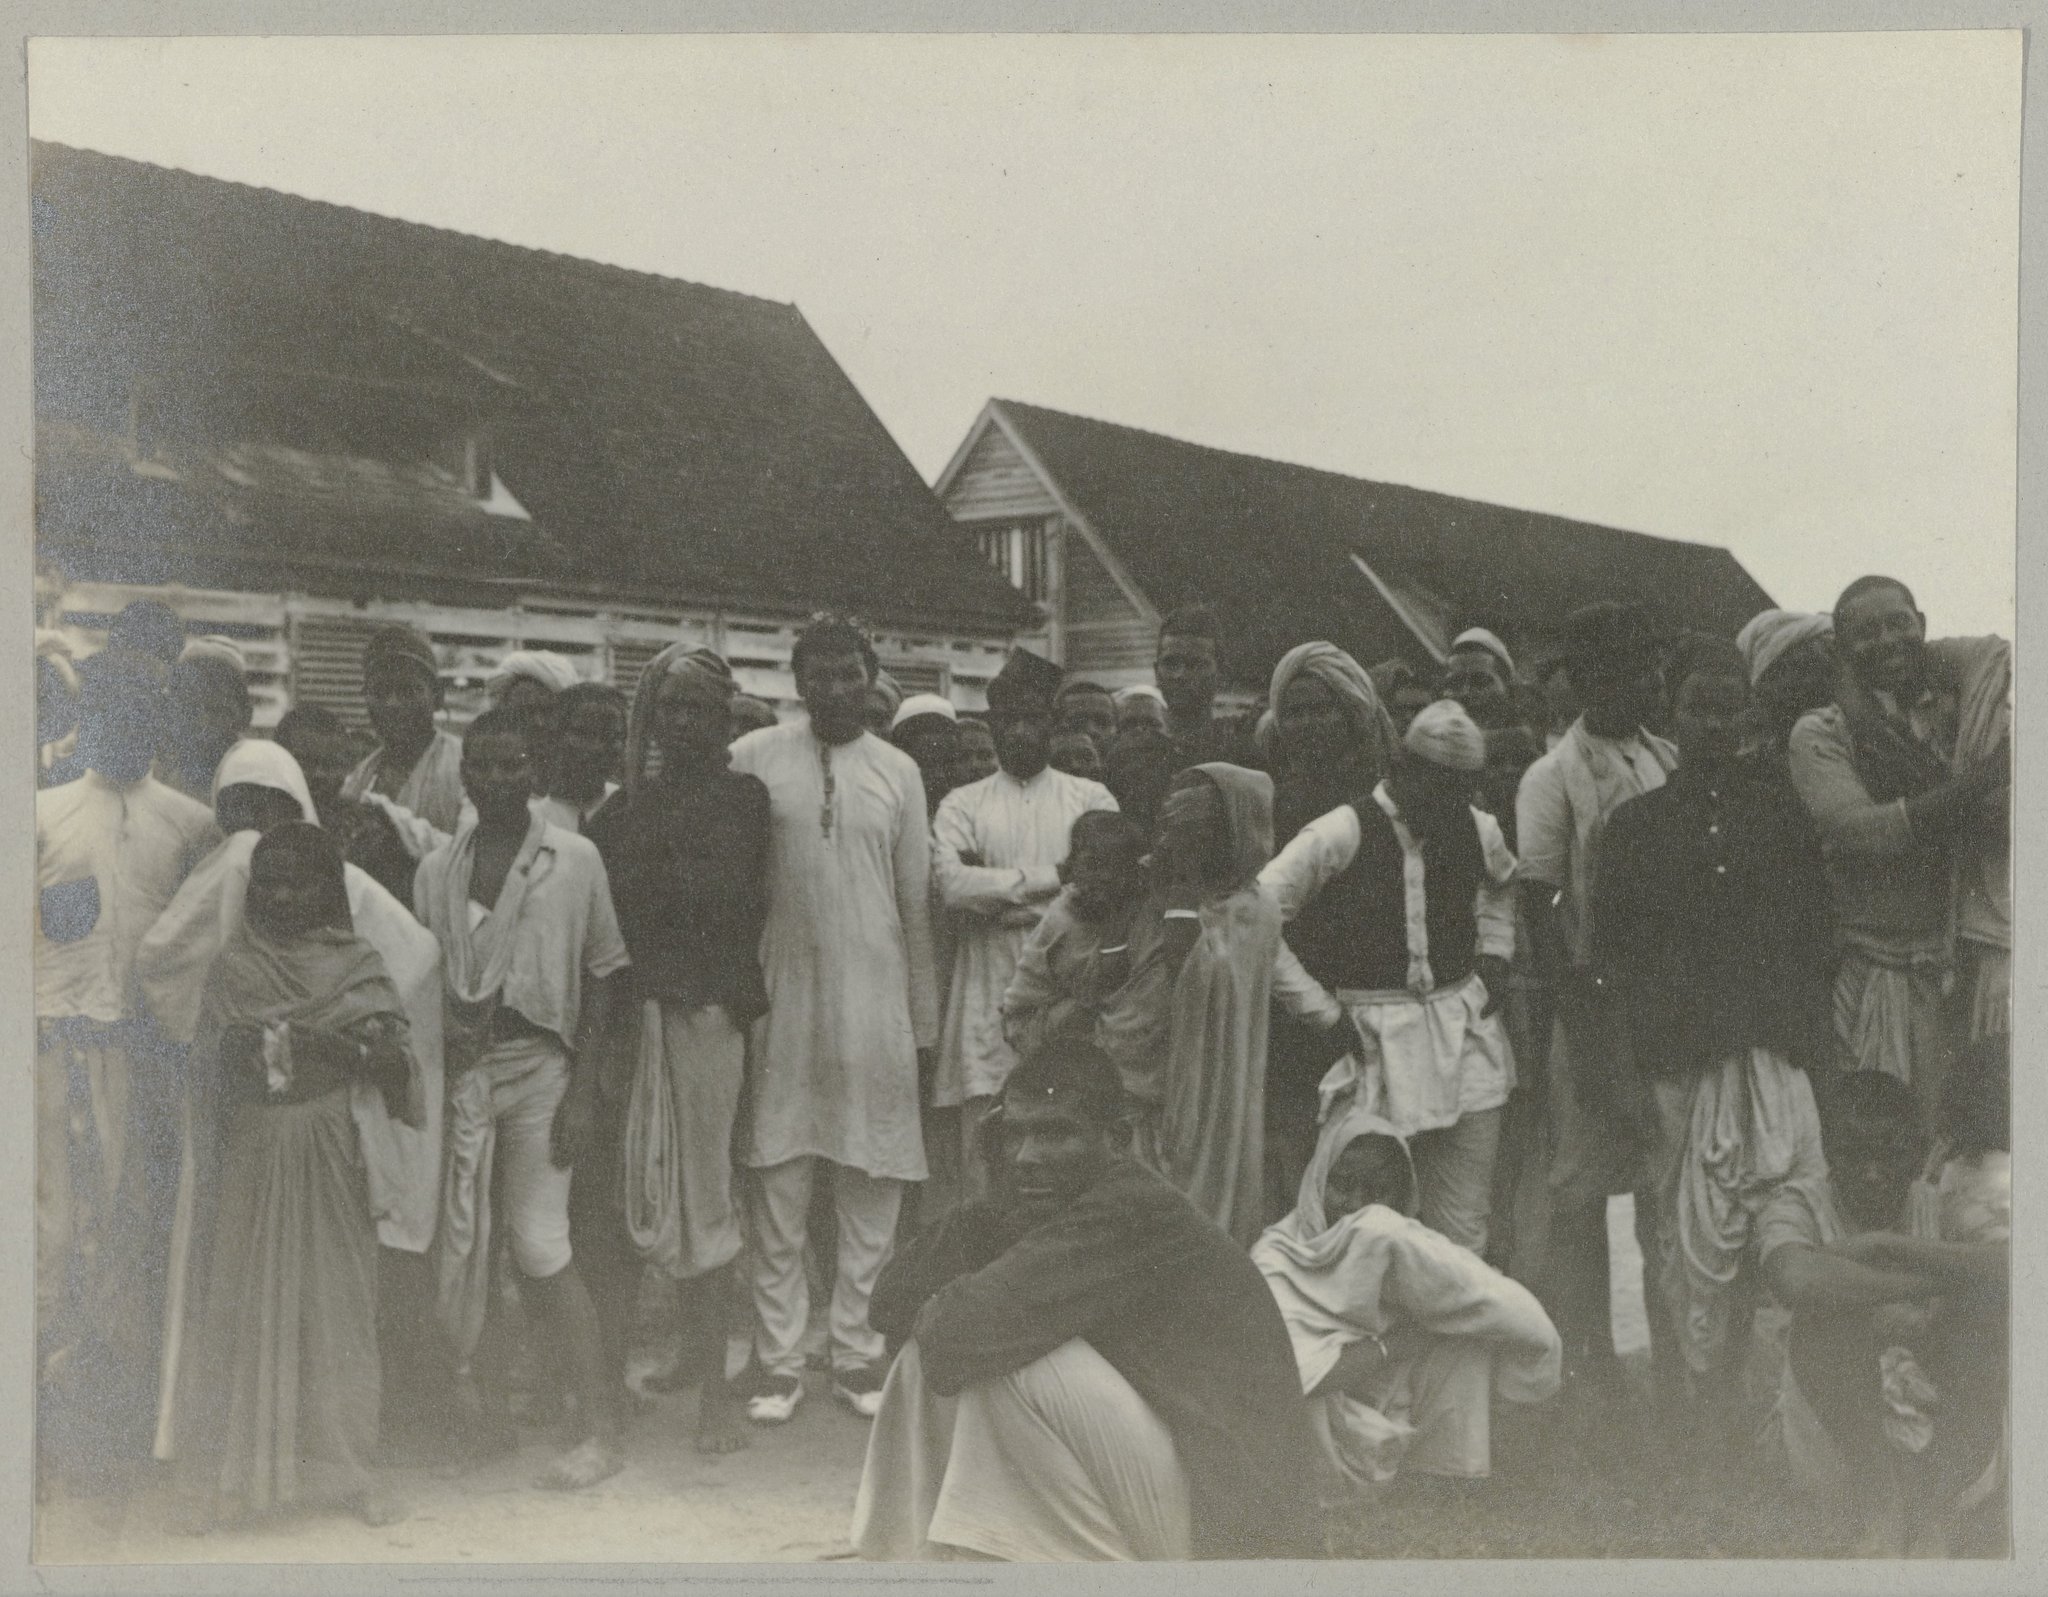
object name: photograph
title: In het koeliedepôt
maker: hendrik doijer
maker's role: engineer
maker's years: 1863-1925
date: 1903-1910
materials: photographic support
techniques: gelatin silver print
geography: suriname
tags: working class, labourers, suriname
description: Een groep contractarbeiders uit Brits-Indië, in het zgn. ‘koeliedepot’, het centrale verzamelpunt voor immigranten in Paramaribo. Onderdeel van het fotoalbum Souvenir de Voyage (deel 5), over het leven van de familie Doijer in en rond de plantage Ma Retraite in Suriname in de jaren 1903-1910